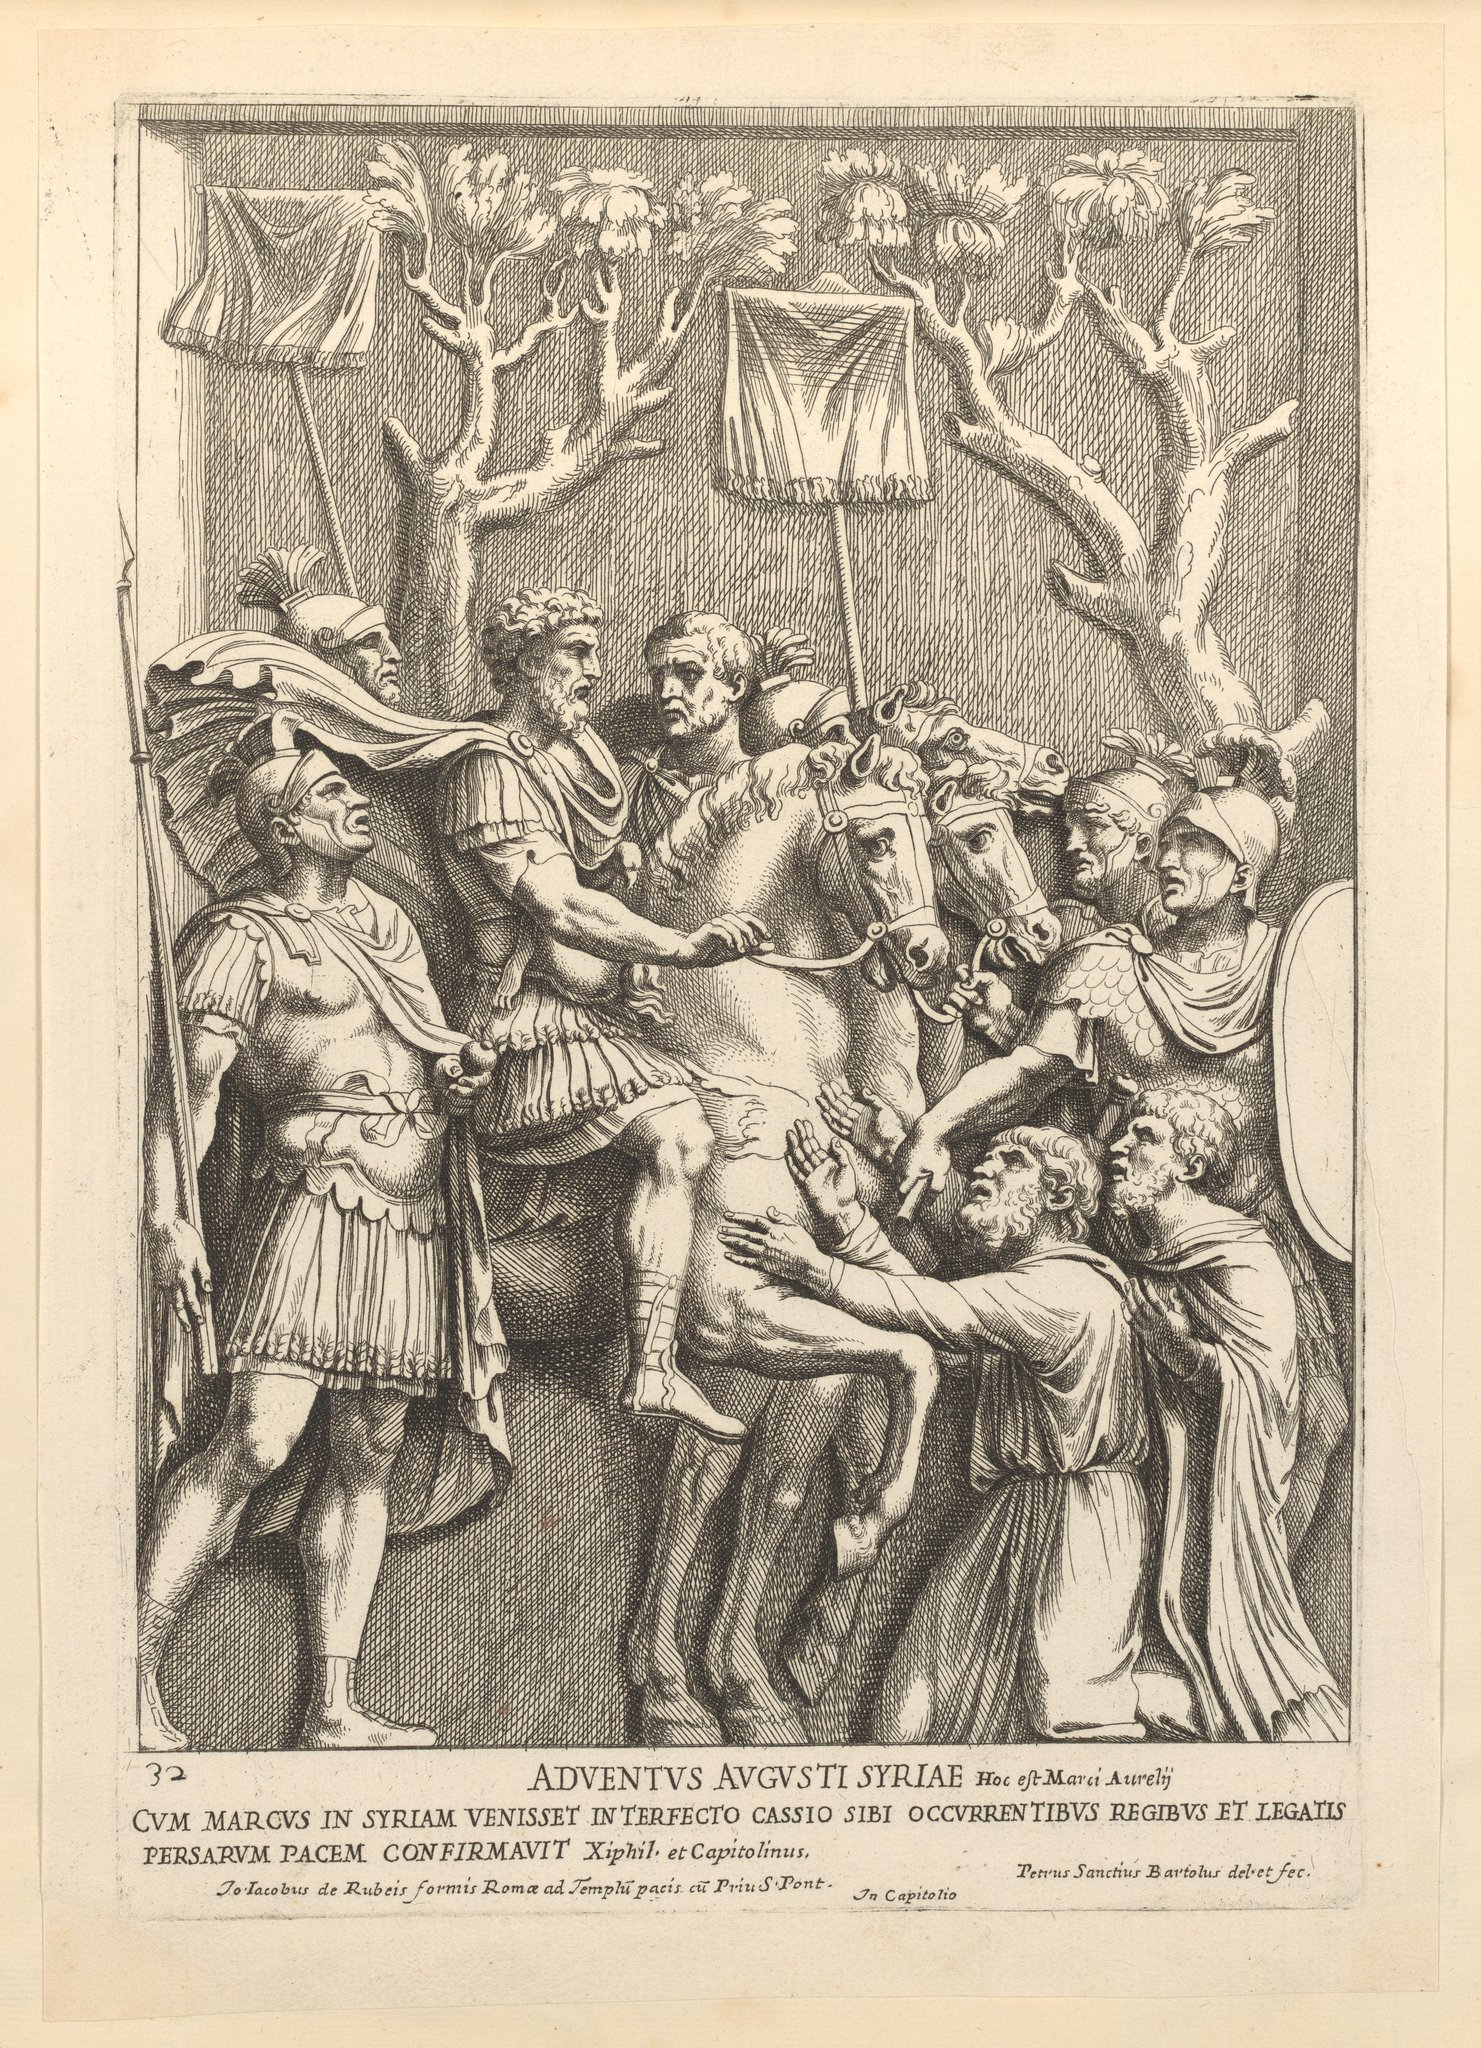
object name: book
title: Admiranda romananum antiquitatum ac veteris sculpturae vestigia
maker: pietro santi bartoli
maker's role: artist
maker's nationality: italian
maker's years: 1615-1700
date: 1693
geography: italy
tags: soldiers,men,horses